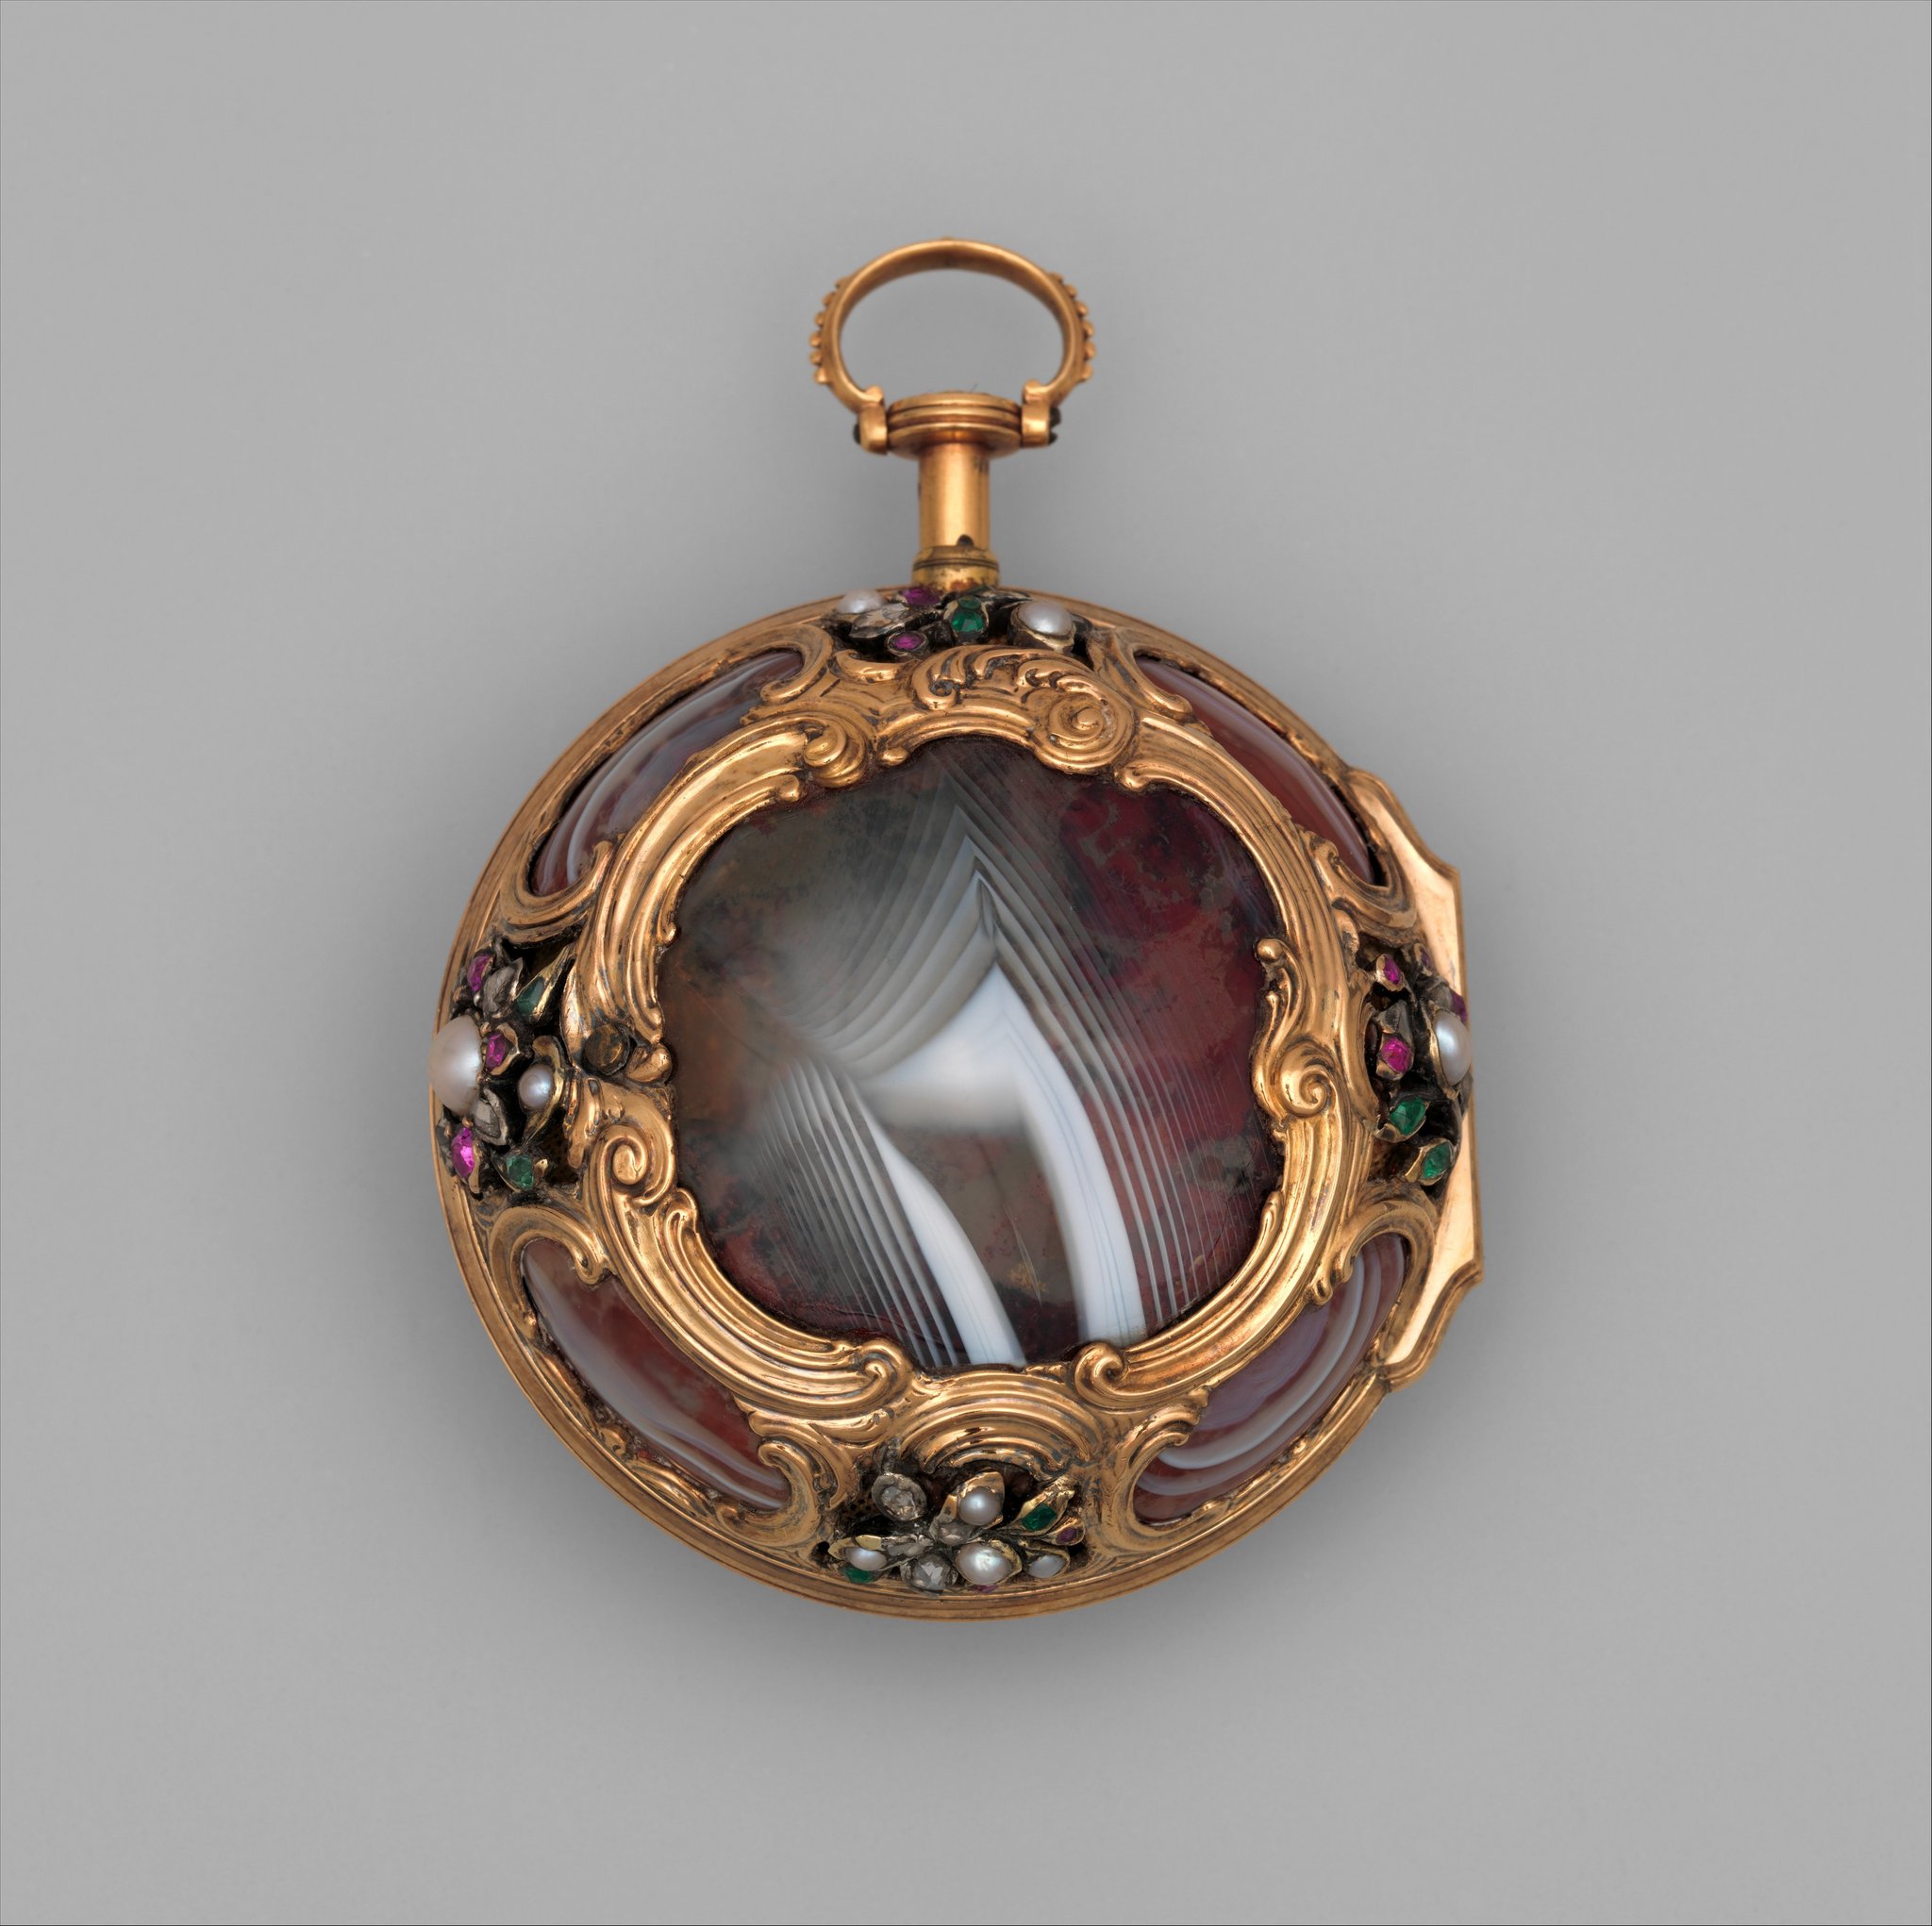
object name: pair case repeating watch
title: Pair-case quarter-repeating watch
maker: john champion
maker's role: maker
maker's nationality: british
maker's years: 1730-1780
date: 1770-1772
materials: diamond, gemstone, enamel, gilt brass, glass, gold, pearl, steel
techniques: painting